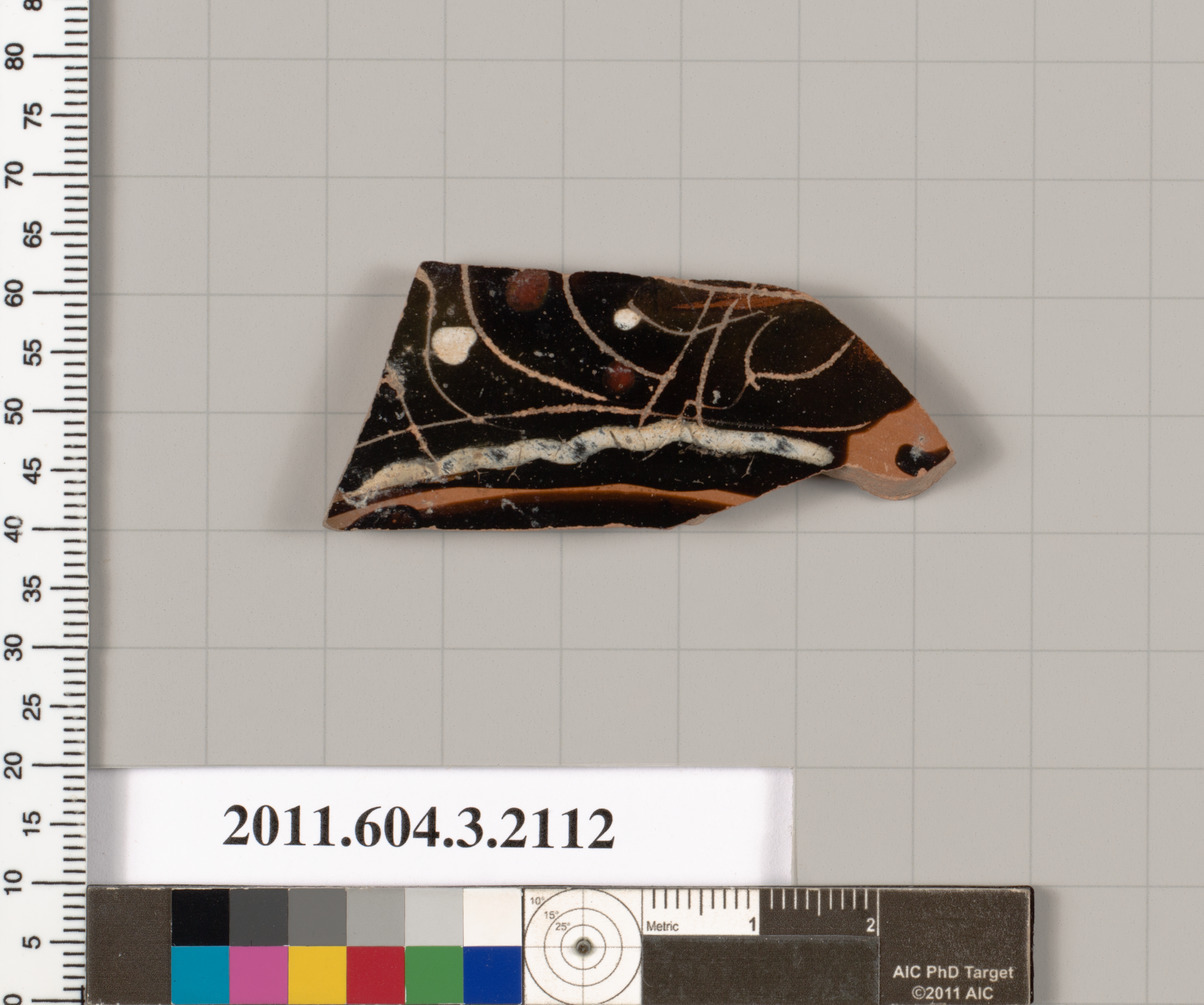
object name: kylix fragment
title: Terracotta fragment of a kylix (drinking cup)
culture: greek, attic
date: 534-468 BCE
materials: terracotta